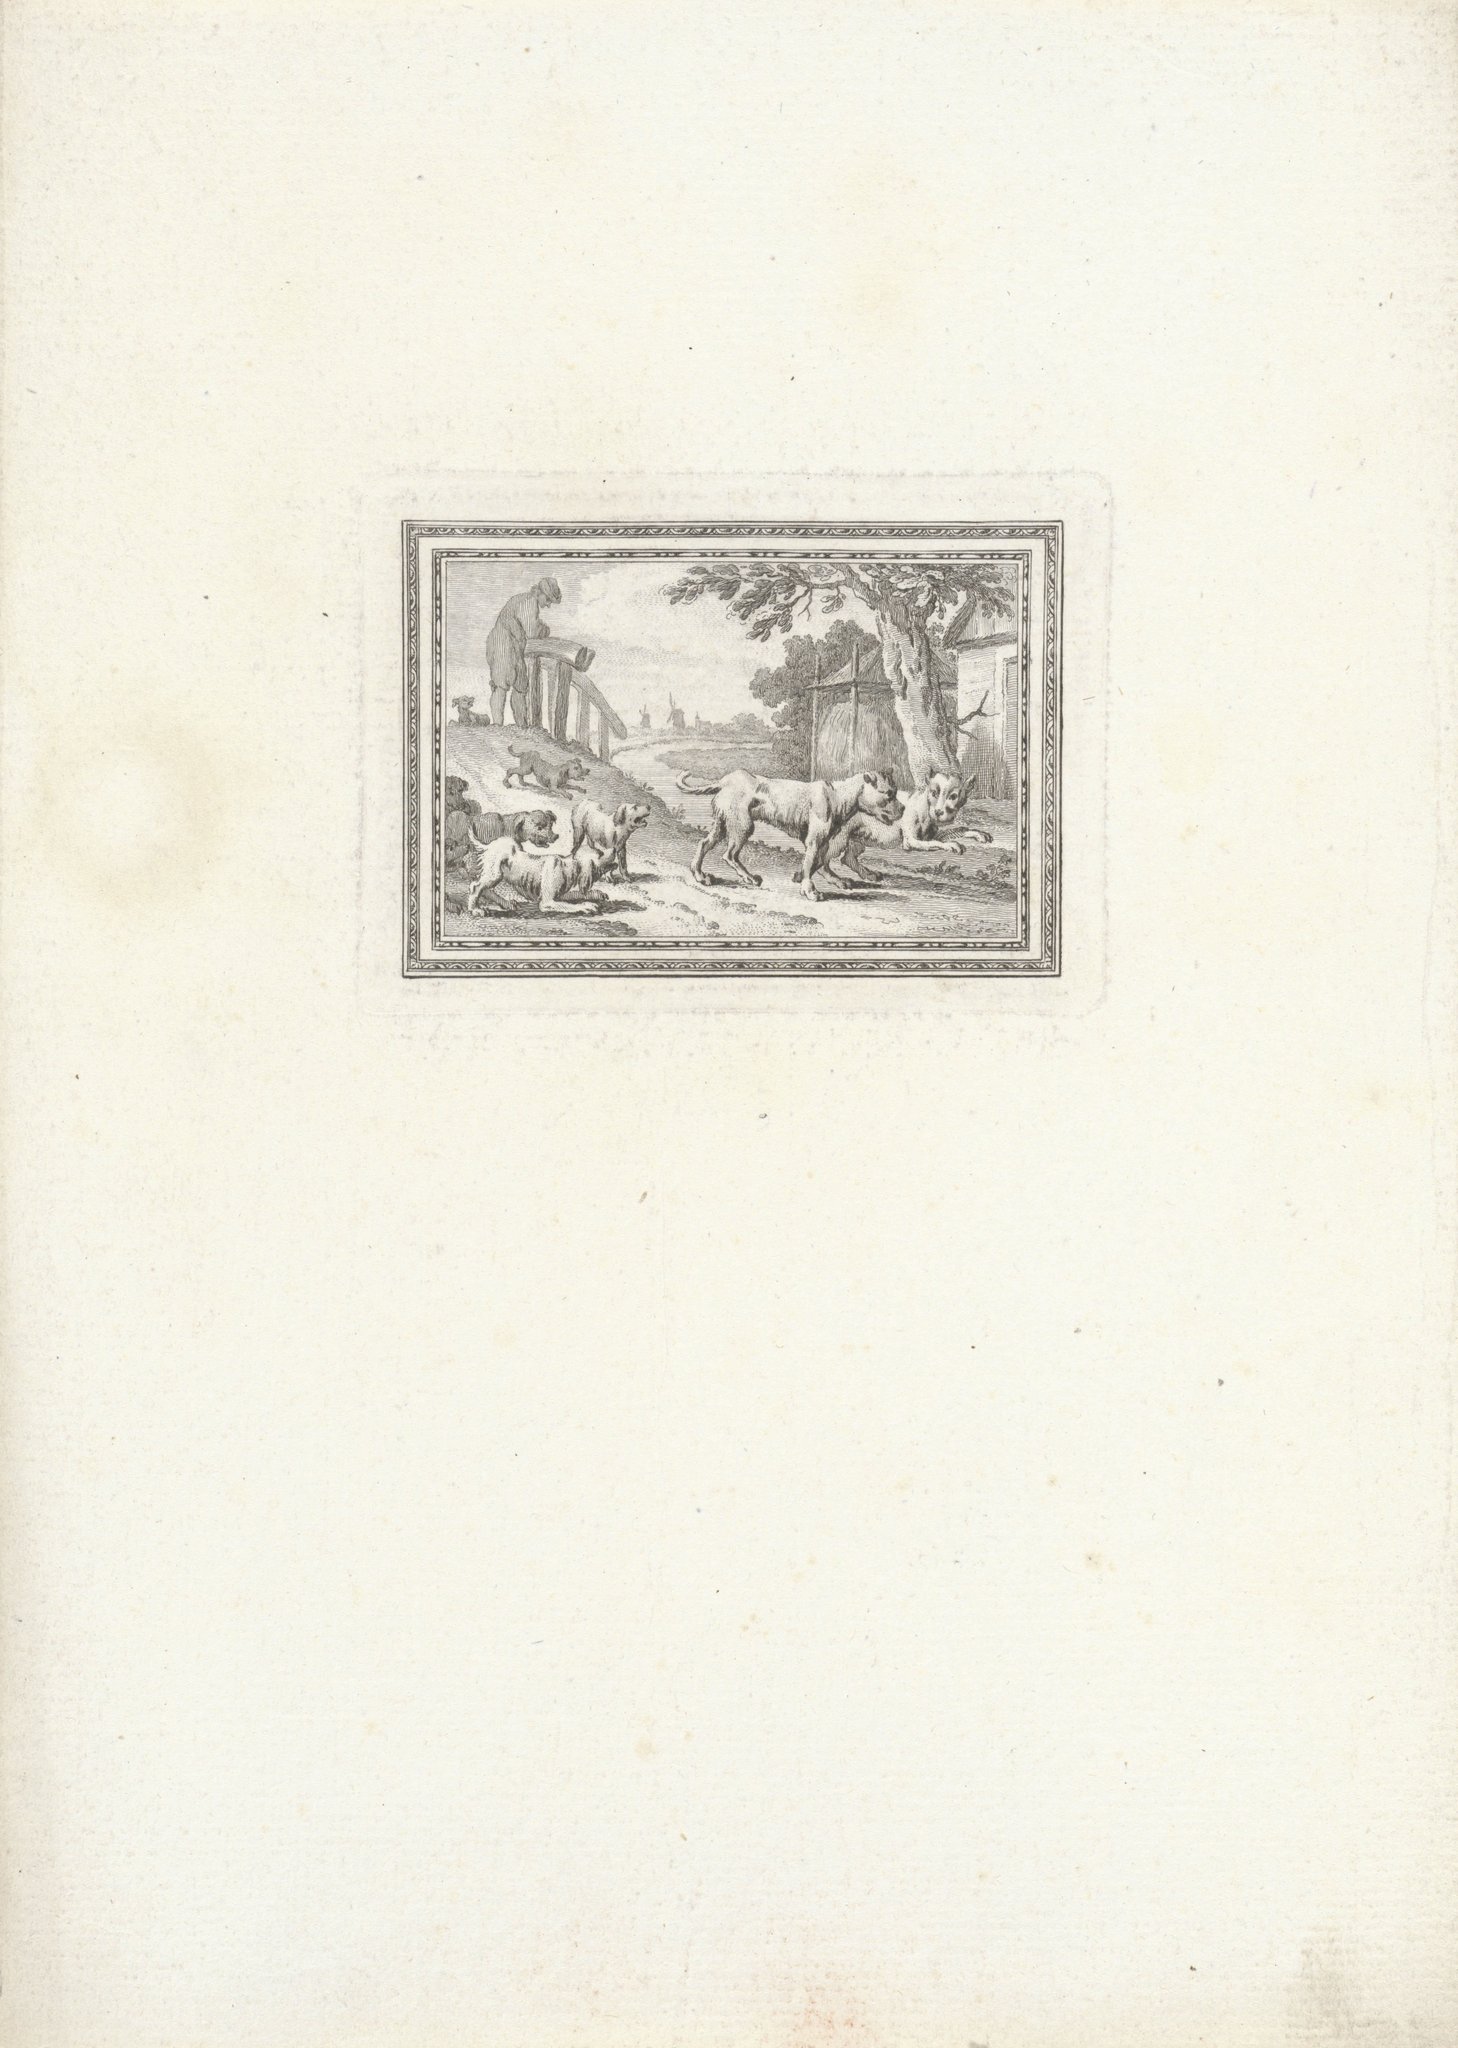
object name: book illustration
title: Twee doggen en een groep keffers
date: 1792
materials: paper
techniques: etching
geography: amsterdam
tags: farm (building), dog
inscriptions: collector's mark: Lugt 2228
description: De dog loopt samen met zijn zoon langs een groep keffers en negeert hen. Zijn zoon vraagt hem hoe hij de keffers verdraagt. Illustratie bij het verhaal 'De dog en zyn zoontje' uit 'Fabelen voor de Nederlandsche jeugd'.